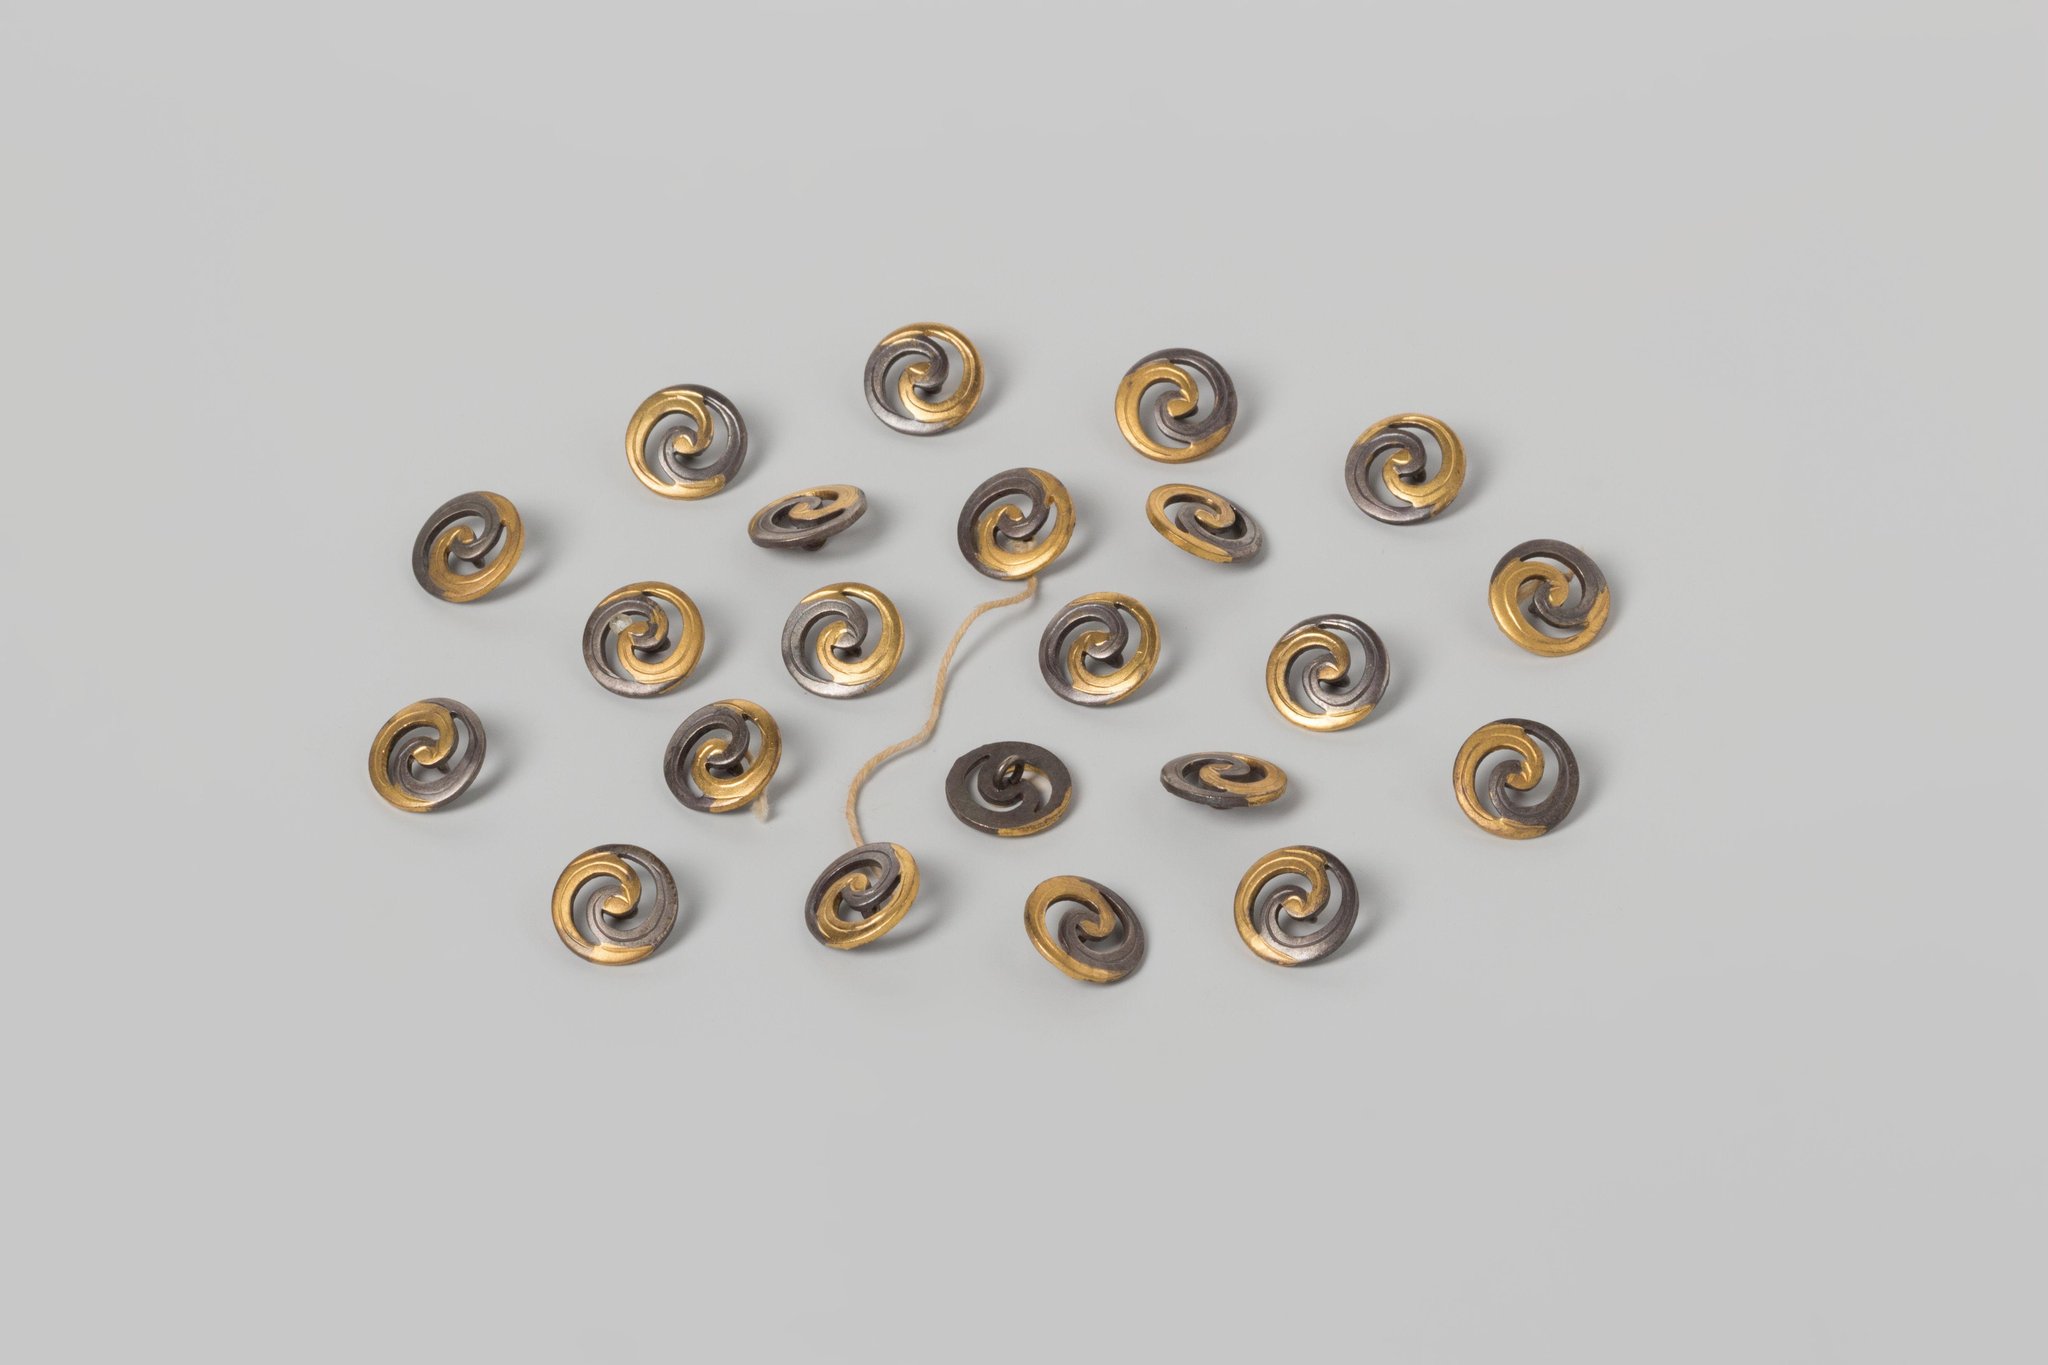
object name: button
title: Knoop, plat en rond, van gedeeltelijk met goudverf beschilderd metaal met krulmotief, gelijkend yin en yang, opengewerkt en gegraveerd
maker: Anonymous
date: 1880-1940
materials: paint, metal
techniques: embroidery, engraving, painting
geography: europe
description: Knoop, plat en rond, van gedeeltelijk met goudverf beschilderd metaal met krulmotief, gelijkend yin en yang, opengewerkt en gegraveerd.